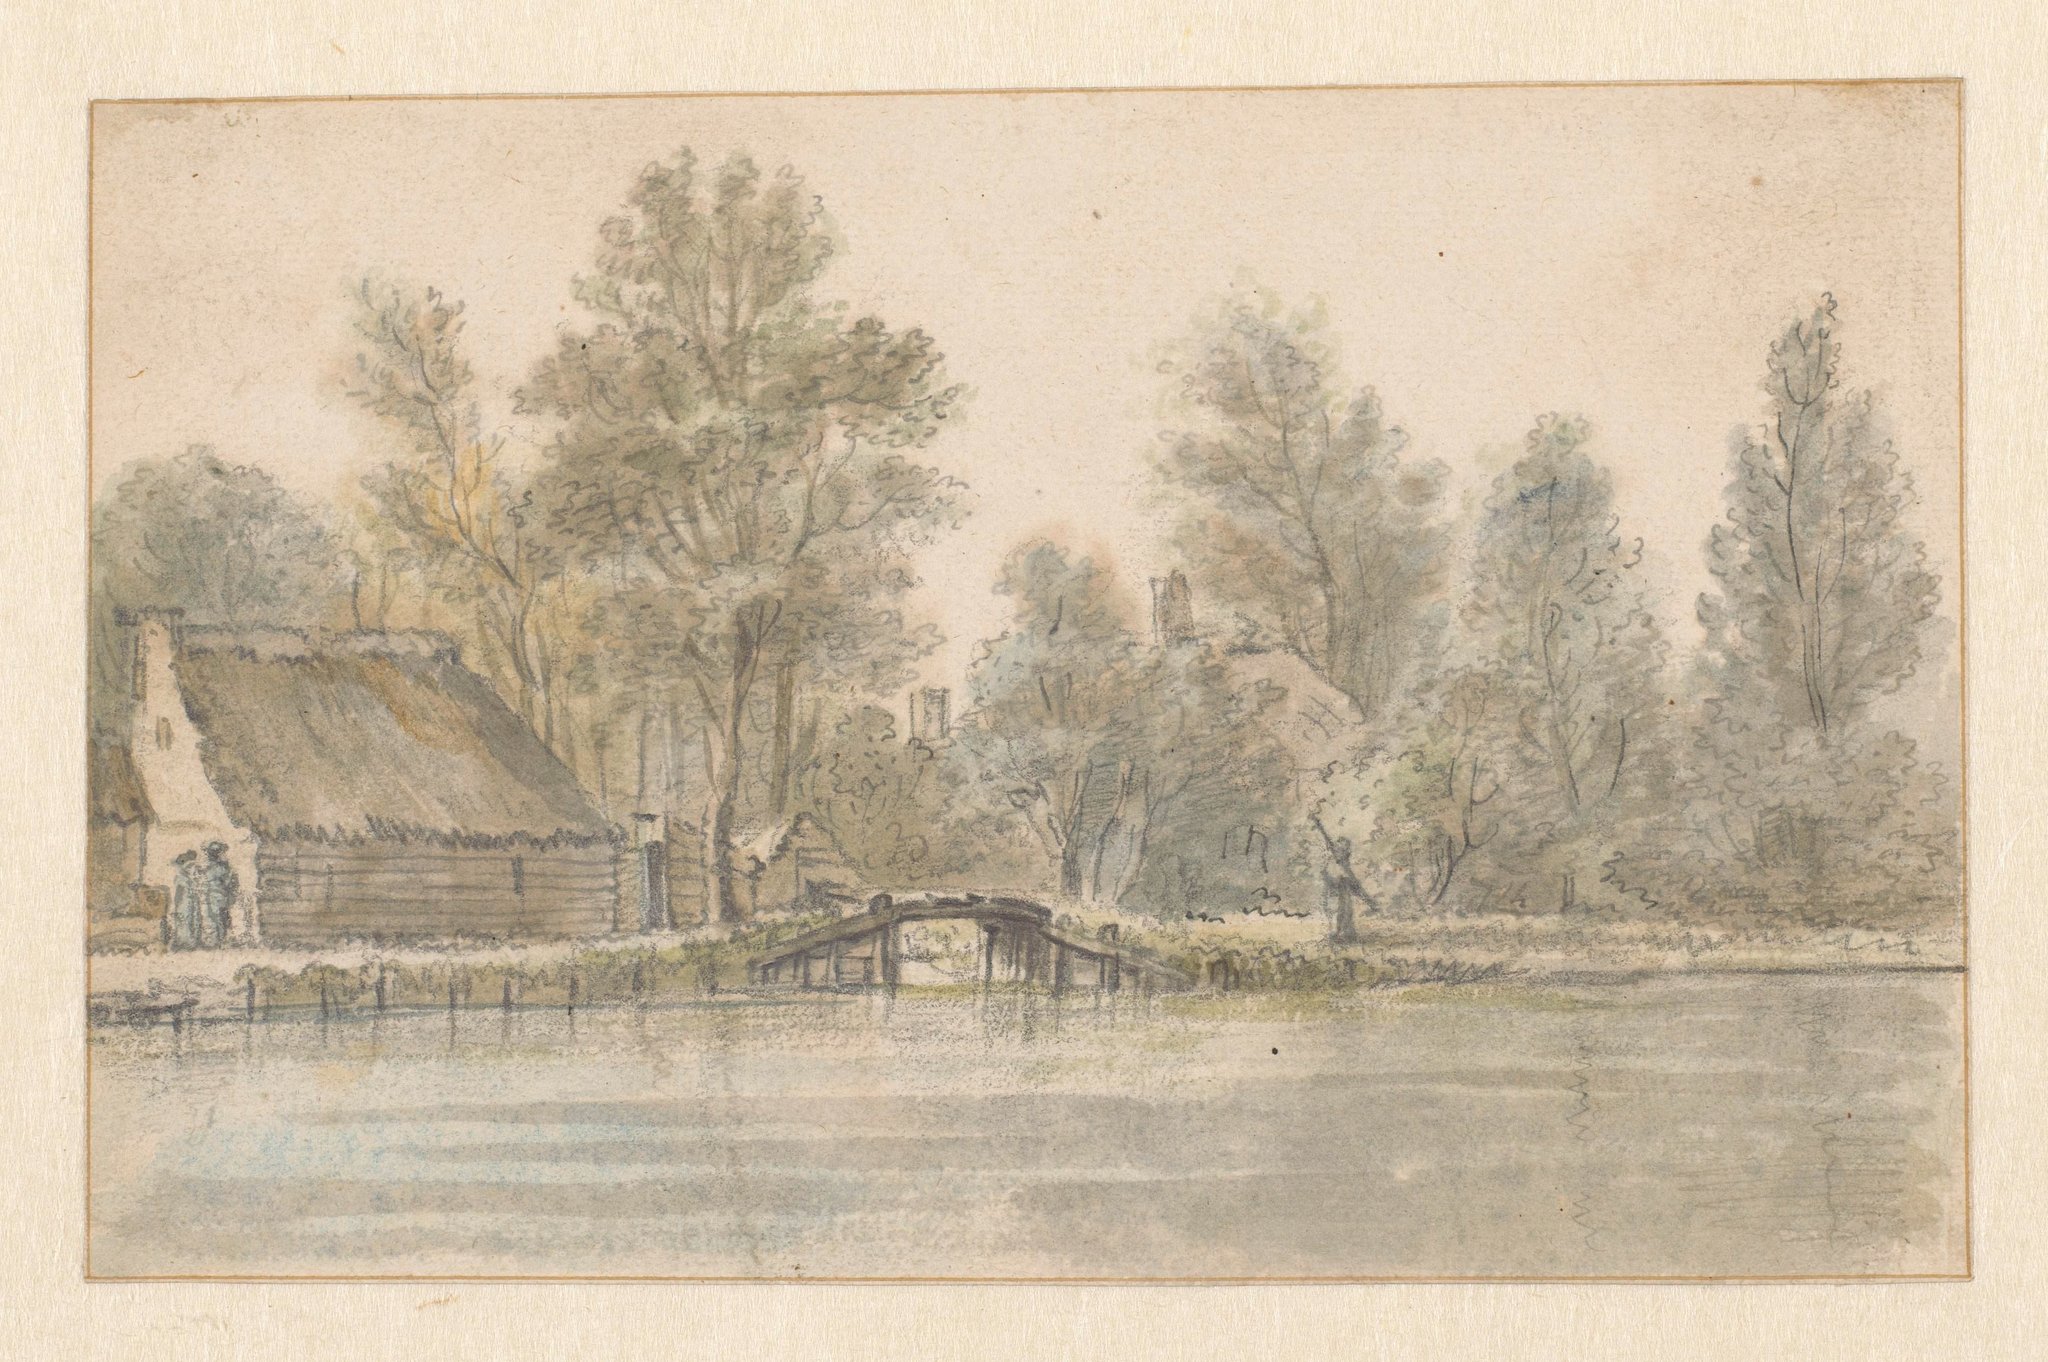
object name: drawing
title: View of a Riverbank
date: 1672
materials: paper, pencil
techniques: brush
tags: river, river bank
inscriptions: date: ‘de 8/25 1672’